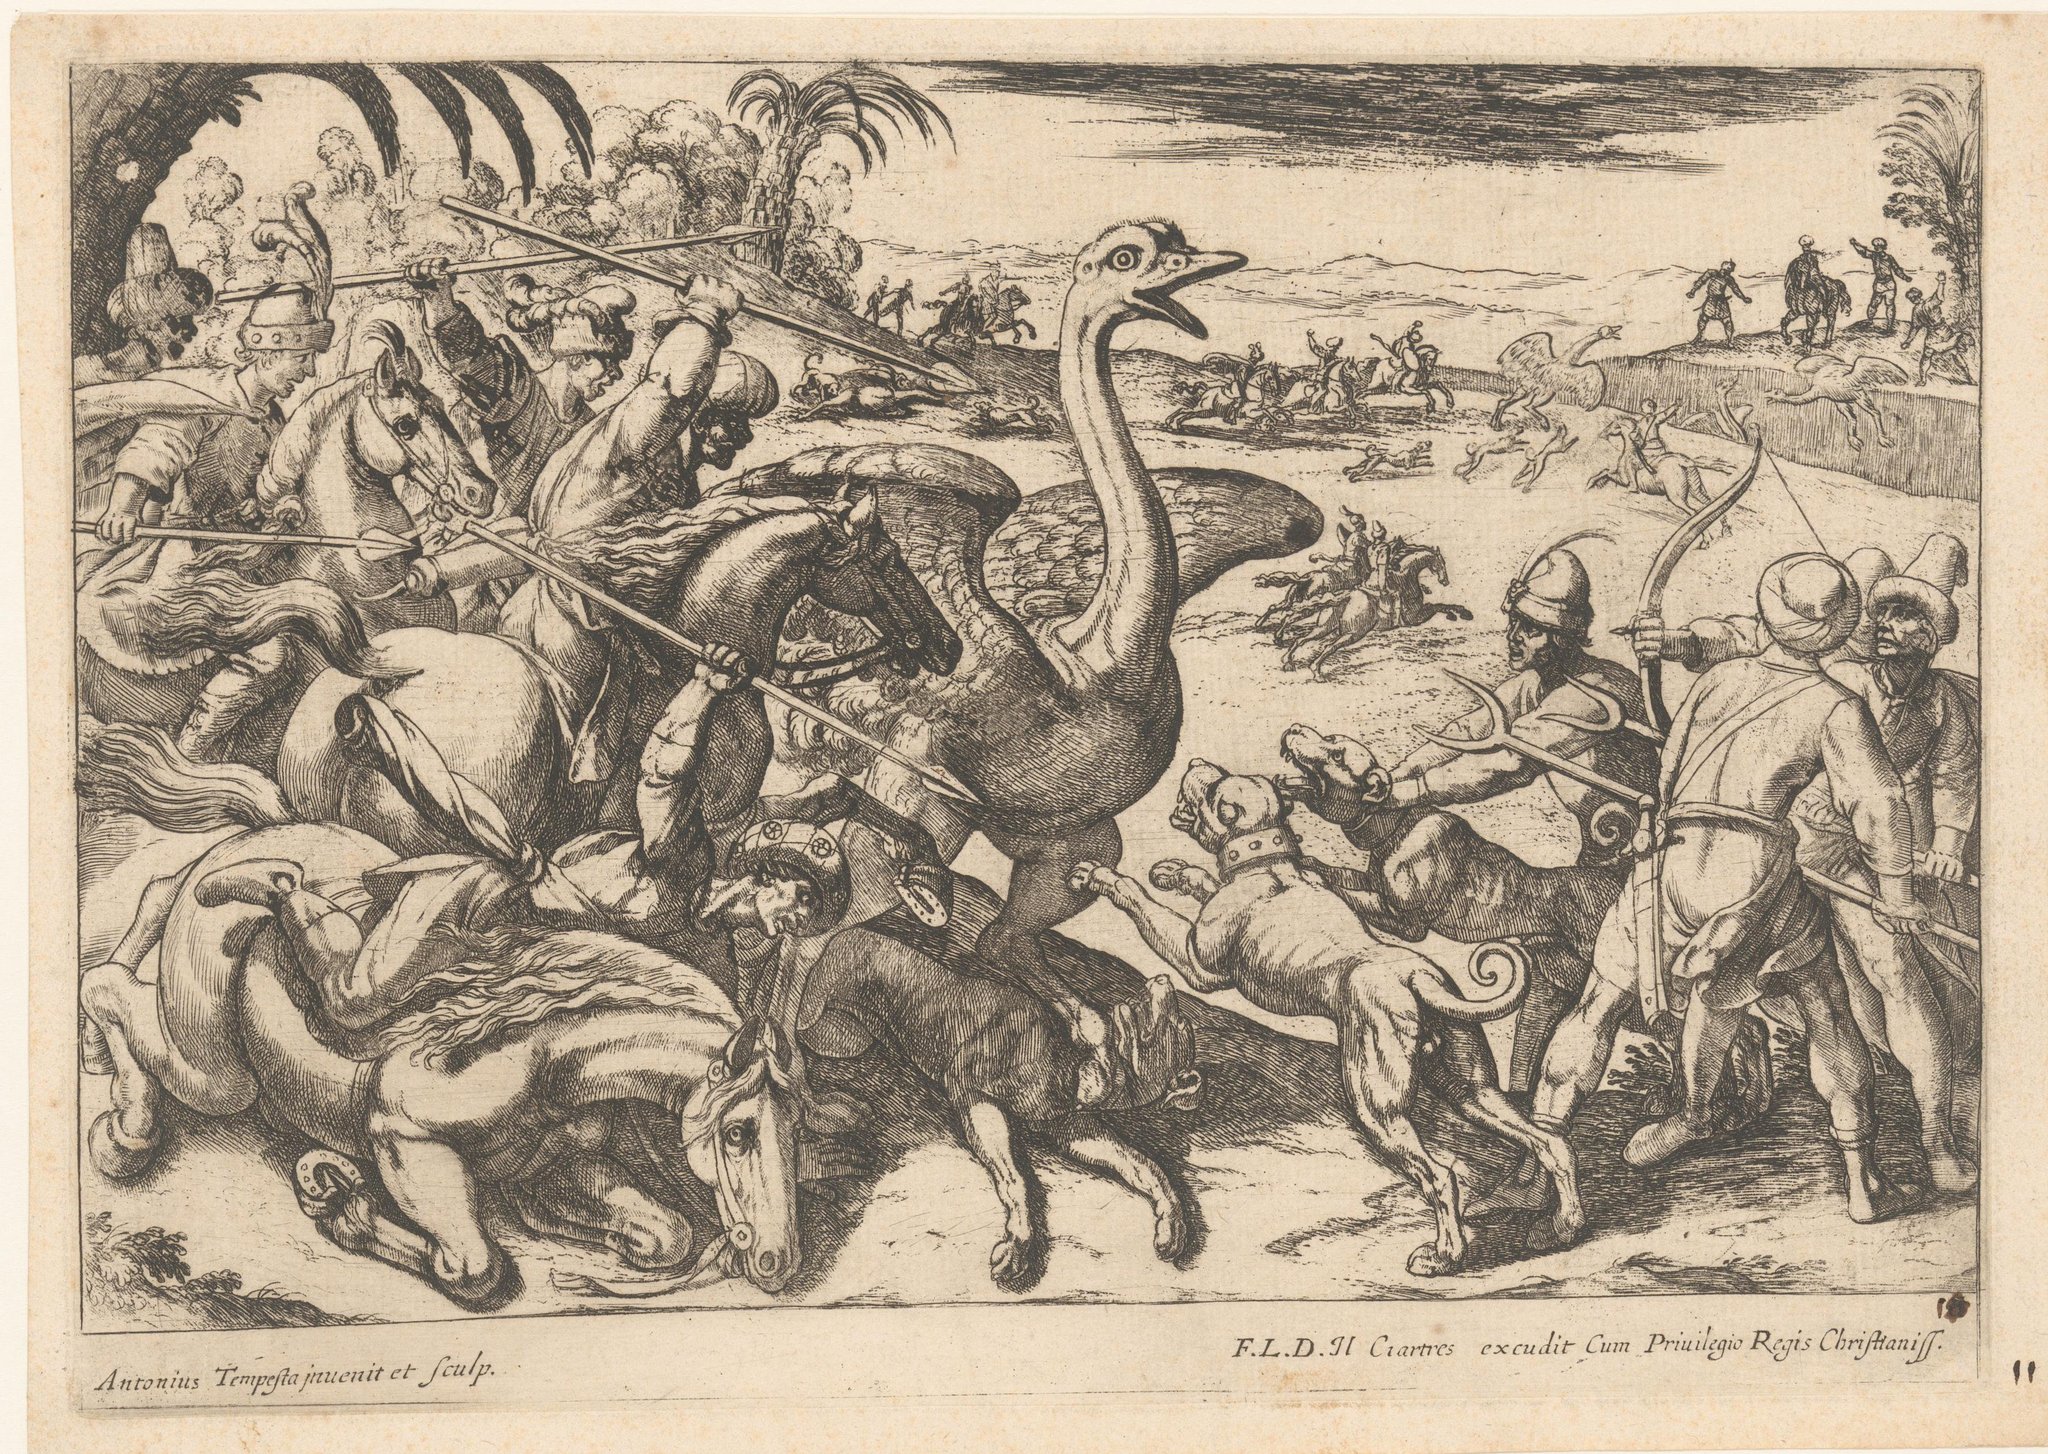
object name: print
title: Jachtscènes (deel 5)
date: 1600-1620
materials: paper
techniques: etching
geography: vatican city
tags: walker and runner birds: ostrich, hunter, hunters hunting (n.b.: in 1988-1990 this notation denoted the concept of 43c11421 'hunters resting during the hunt'), bird hunting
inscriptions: collector's mark: Lugt 11, number: ‘11’, collector's mark: ‘Hinloopen’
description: Landschap met Oosterse jagers en jachthonden jagend op struisvogels. Op de achtergrond worden struisvogels in een greppel gejaagd.